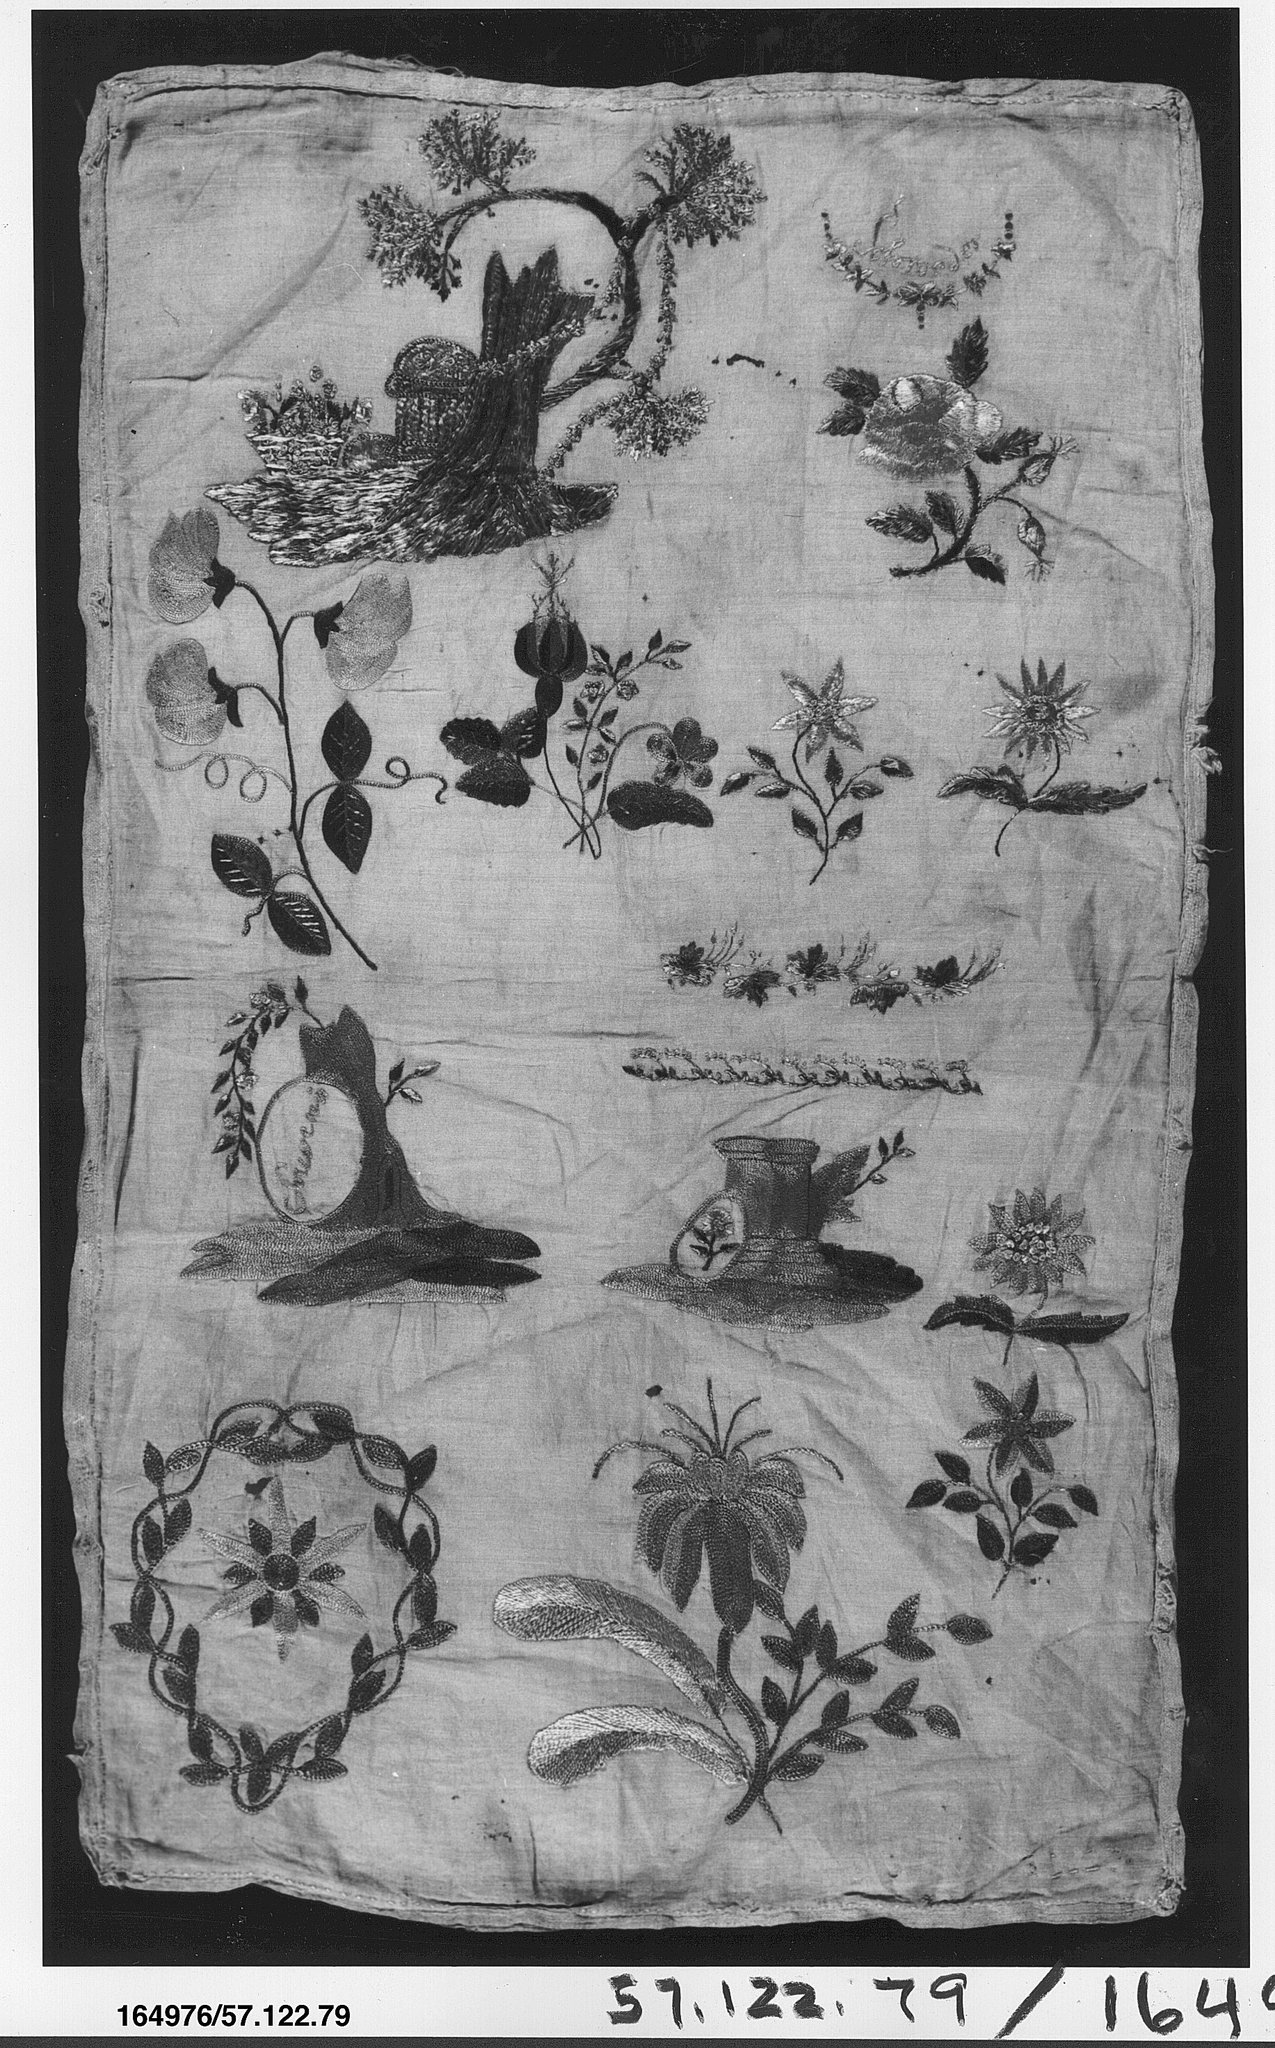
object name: sampler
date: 1801-1900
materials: cotton, silk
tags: flowers,leaves